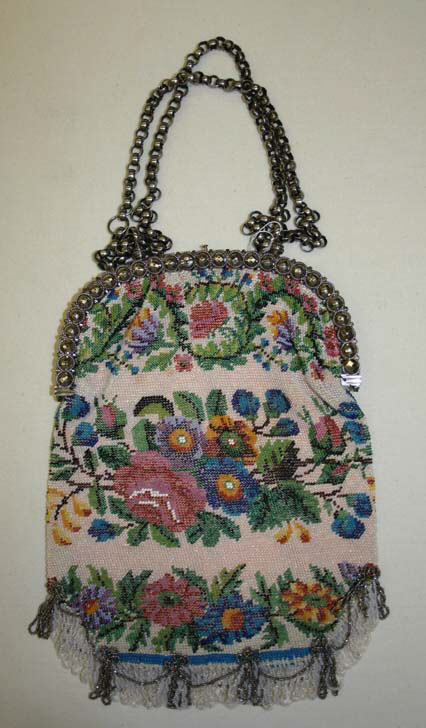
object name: bag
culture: french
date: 1820-1830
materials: metal